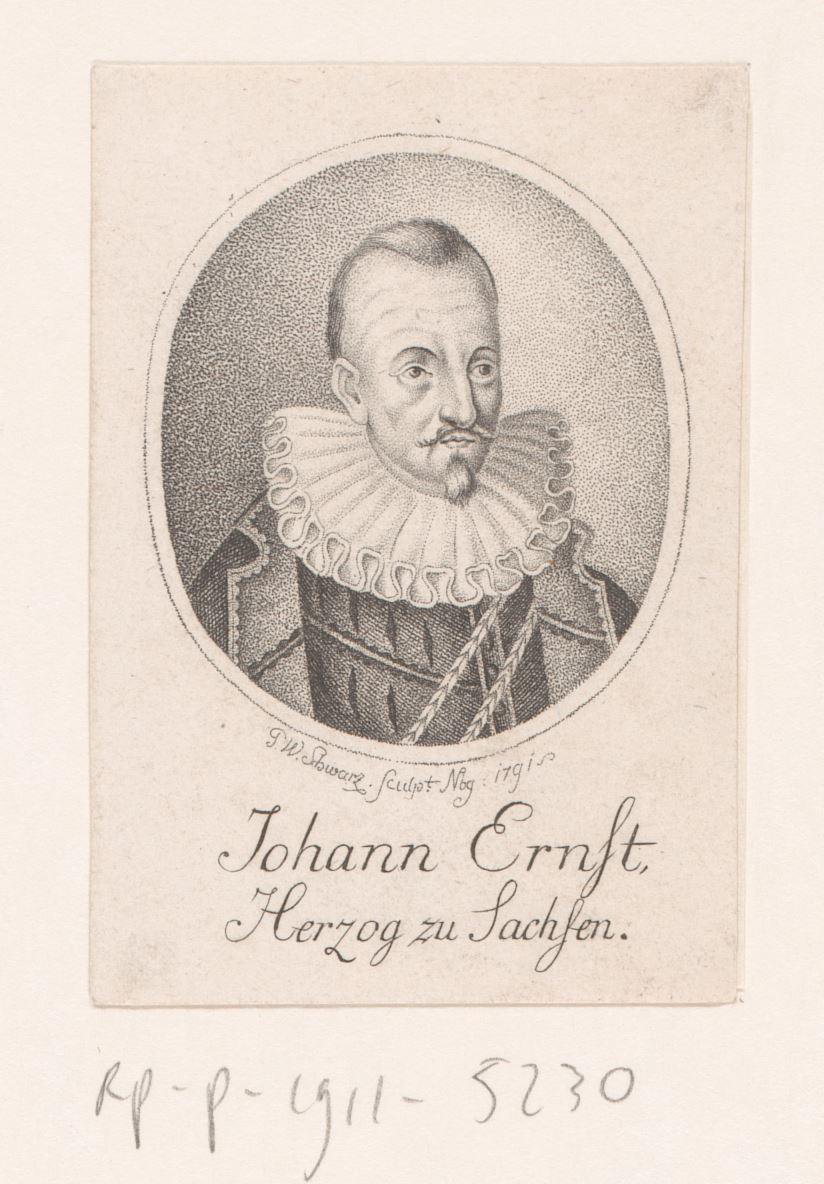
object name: print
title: Portret van Johan Ernst, hertog van Saksen-Coburg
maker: paul wolfgang schwarz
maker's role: print maker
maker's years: -1815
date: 1791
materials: paper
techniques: engraving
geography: nuremberg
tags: historical persons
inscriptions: collector's mark: Lugt 2228